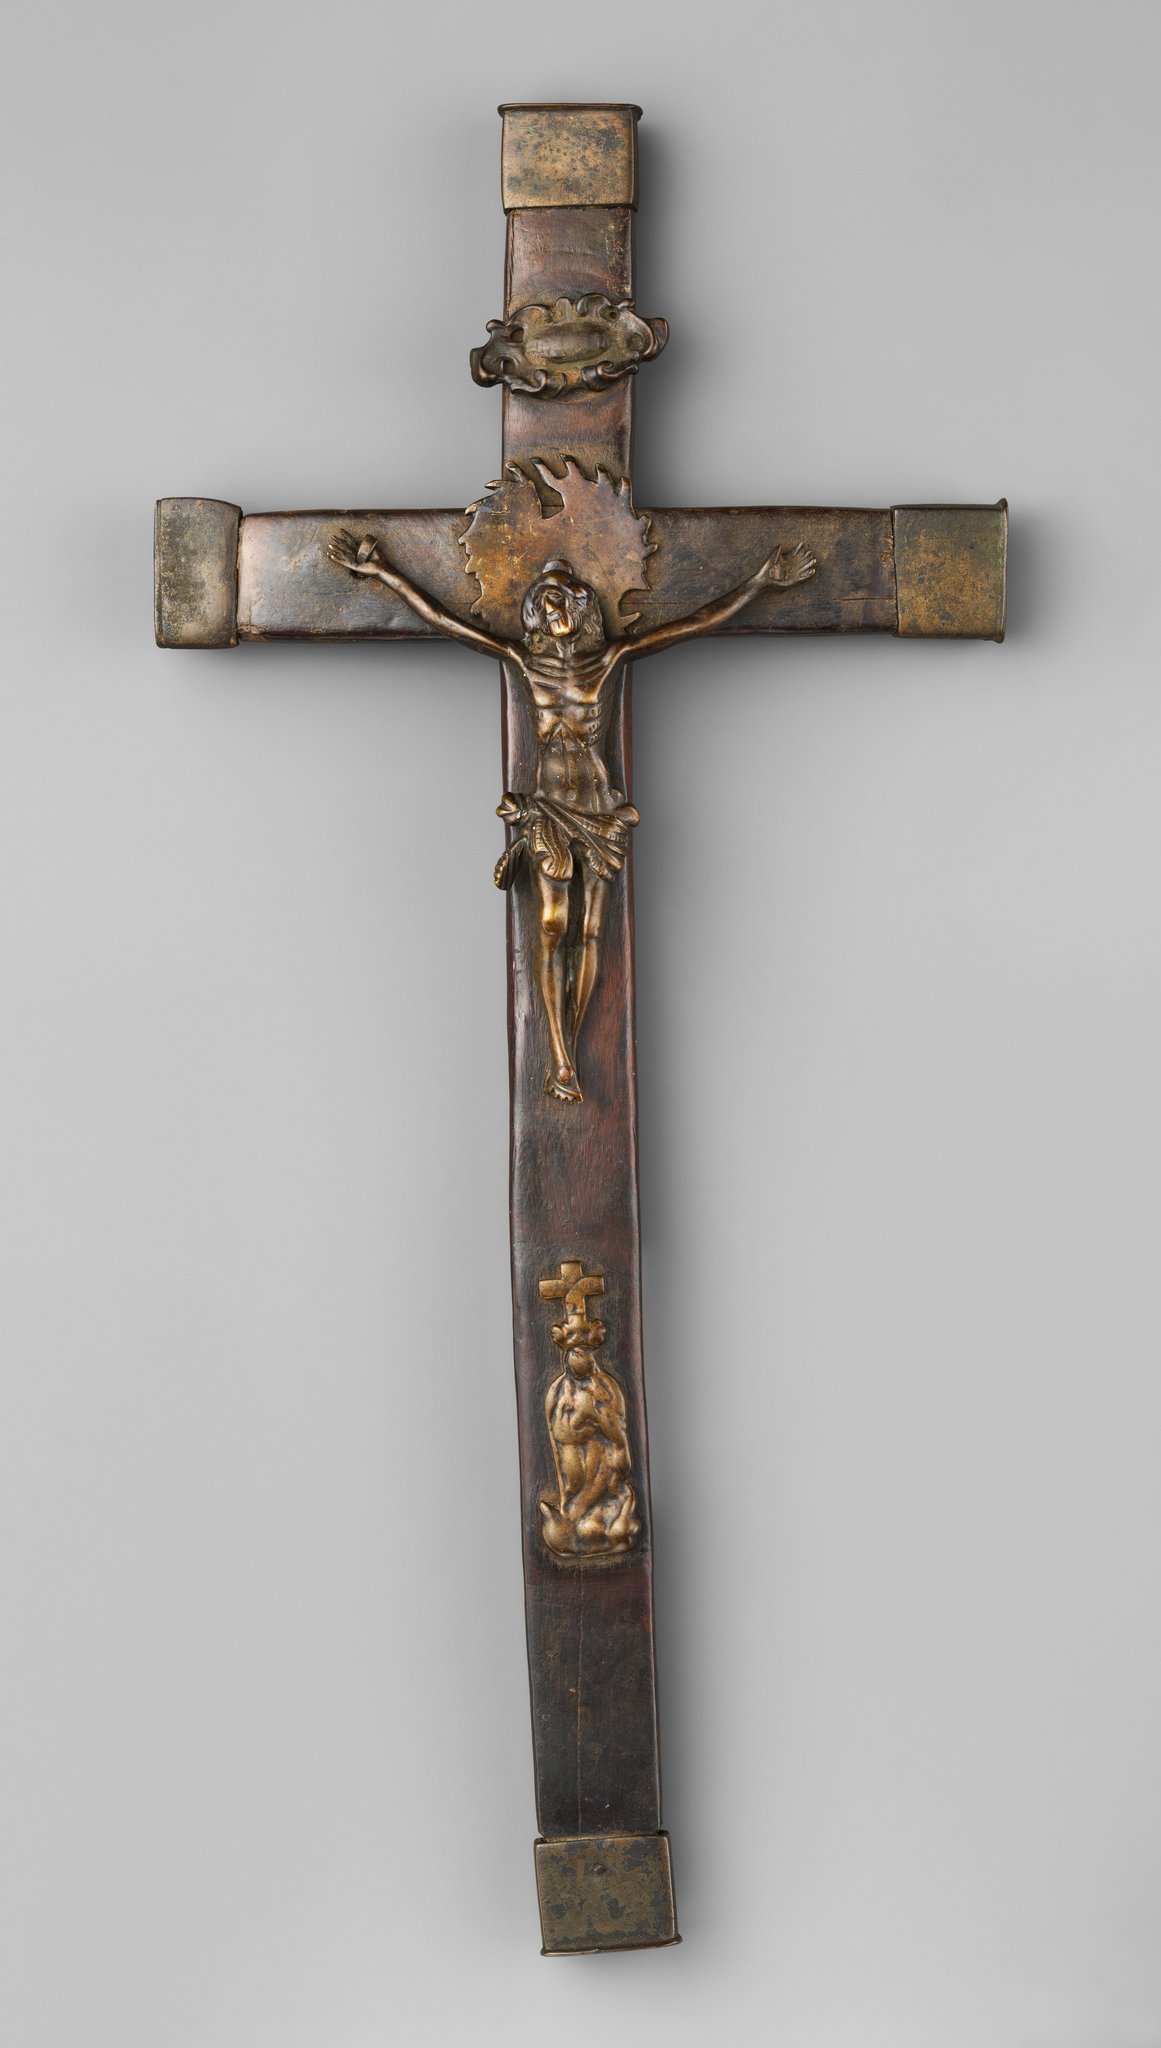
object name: crucifix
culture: kongo, kongo kingdom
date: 1501-1700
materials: brass, bronze, copper, copper alloy, wood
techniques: casting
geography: angola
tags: christ,cross,crucifixion